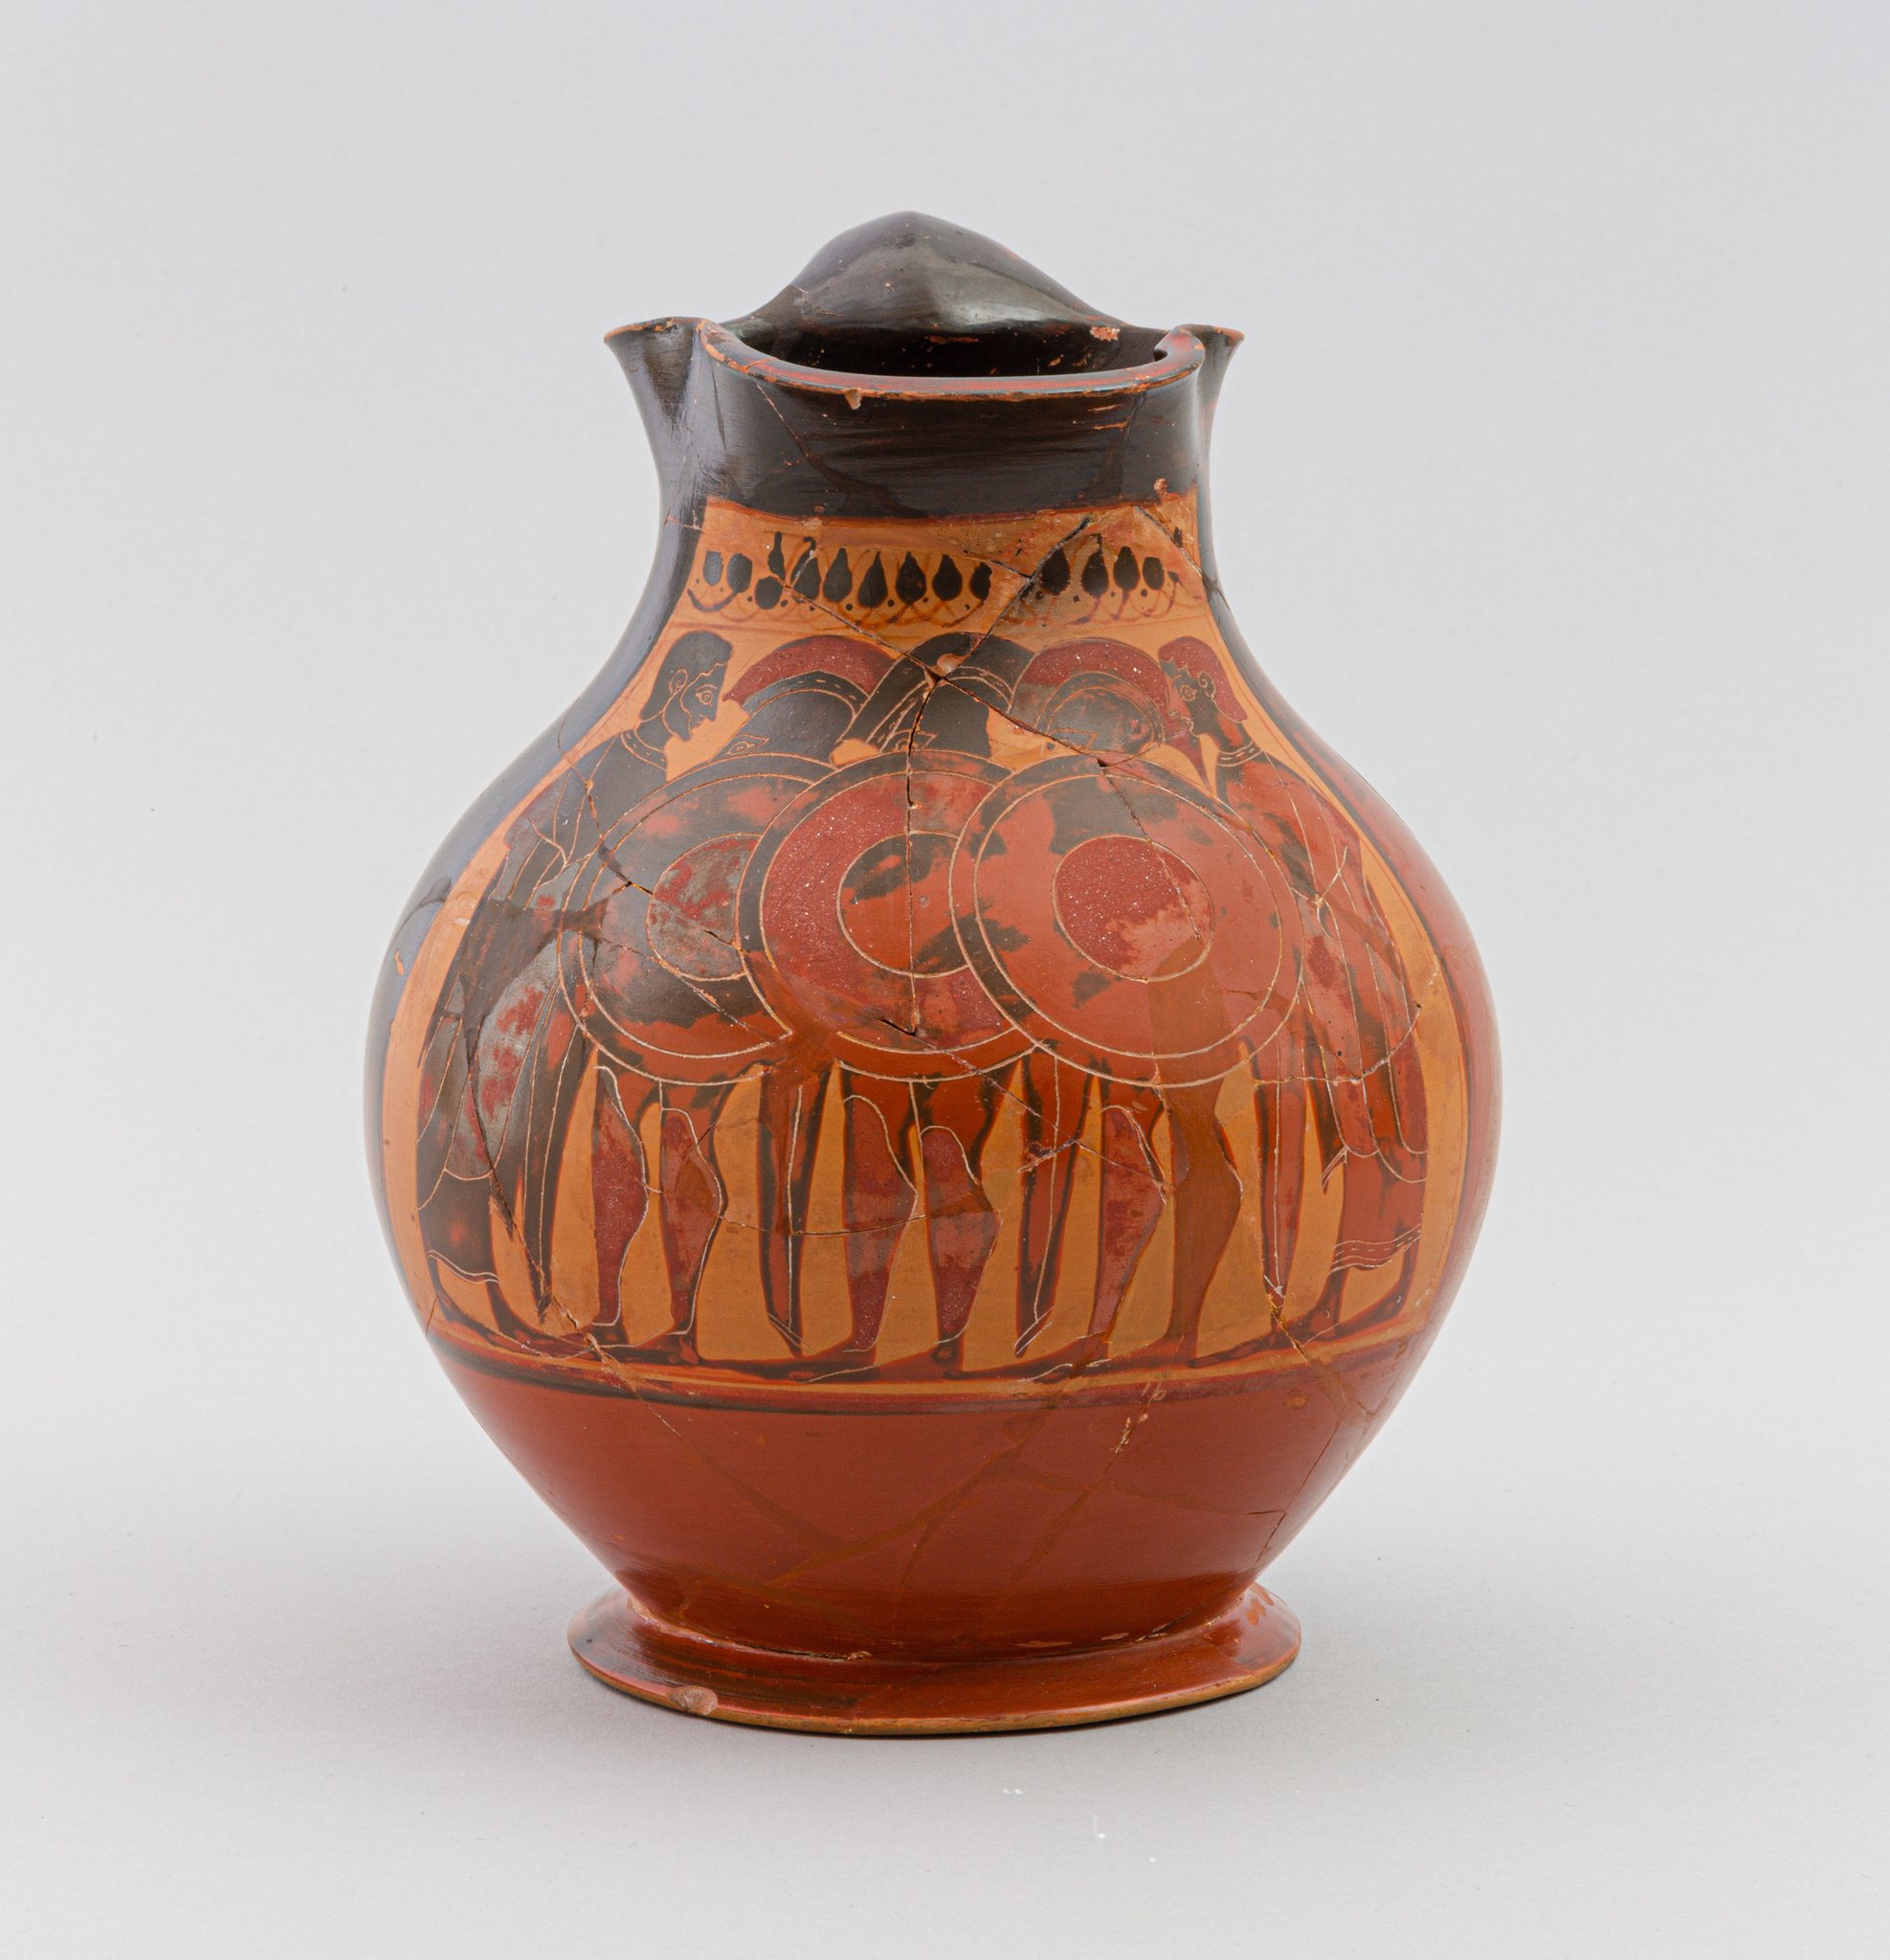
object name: oinochoe, chou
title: Terracotta oinochoe: chous (jug)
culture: greek, attic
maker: amasis painter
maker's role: artist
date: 560 BCE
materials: terracotta